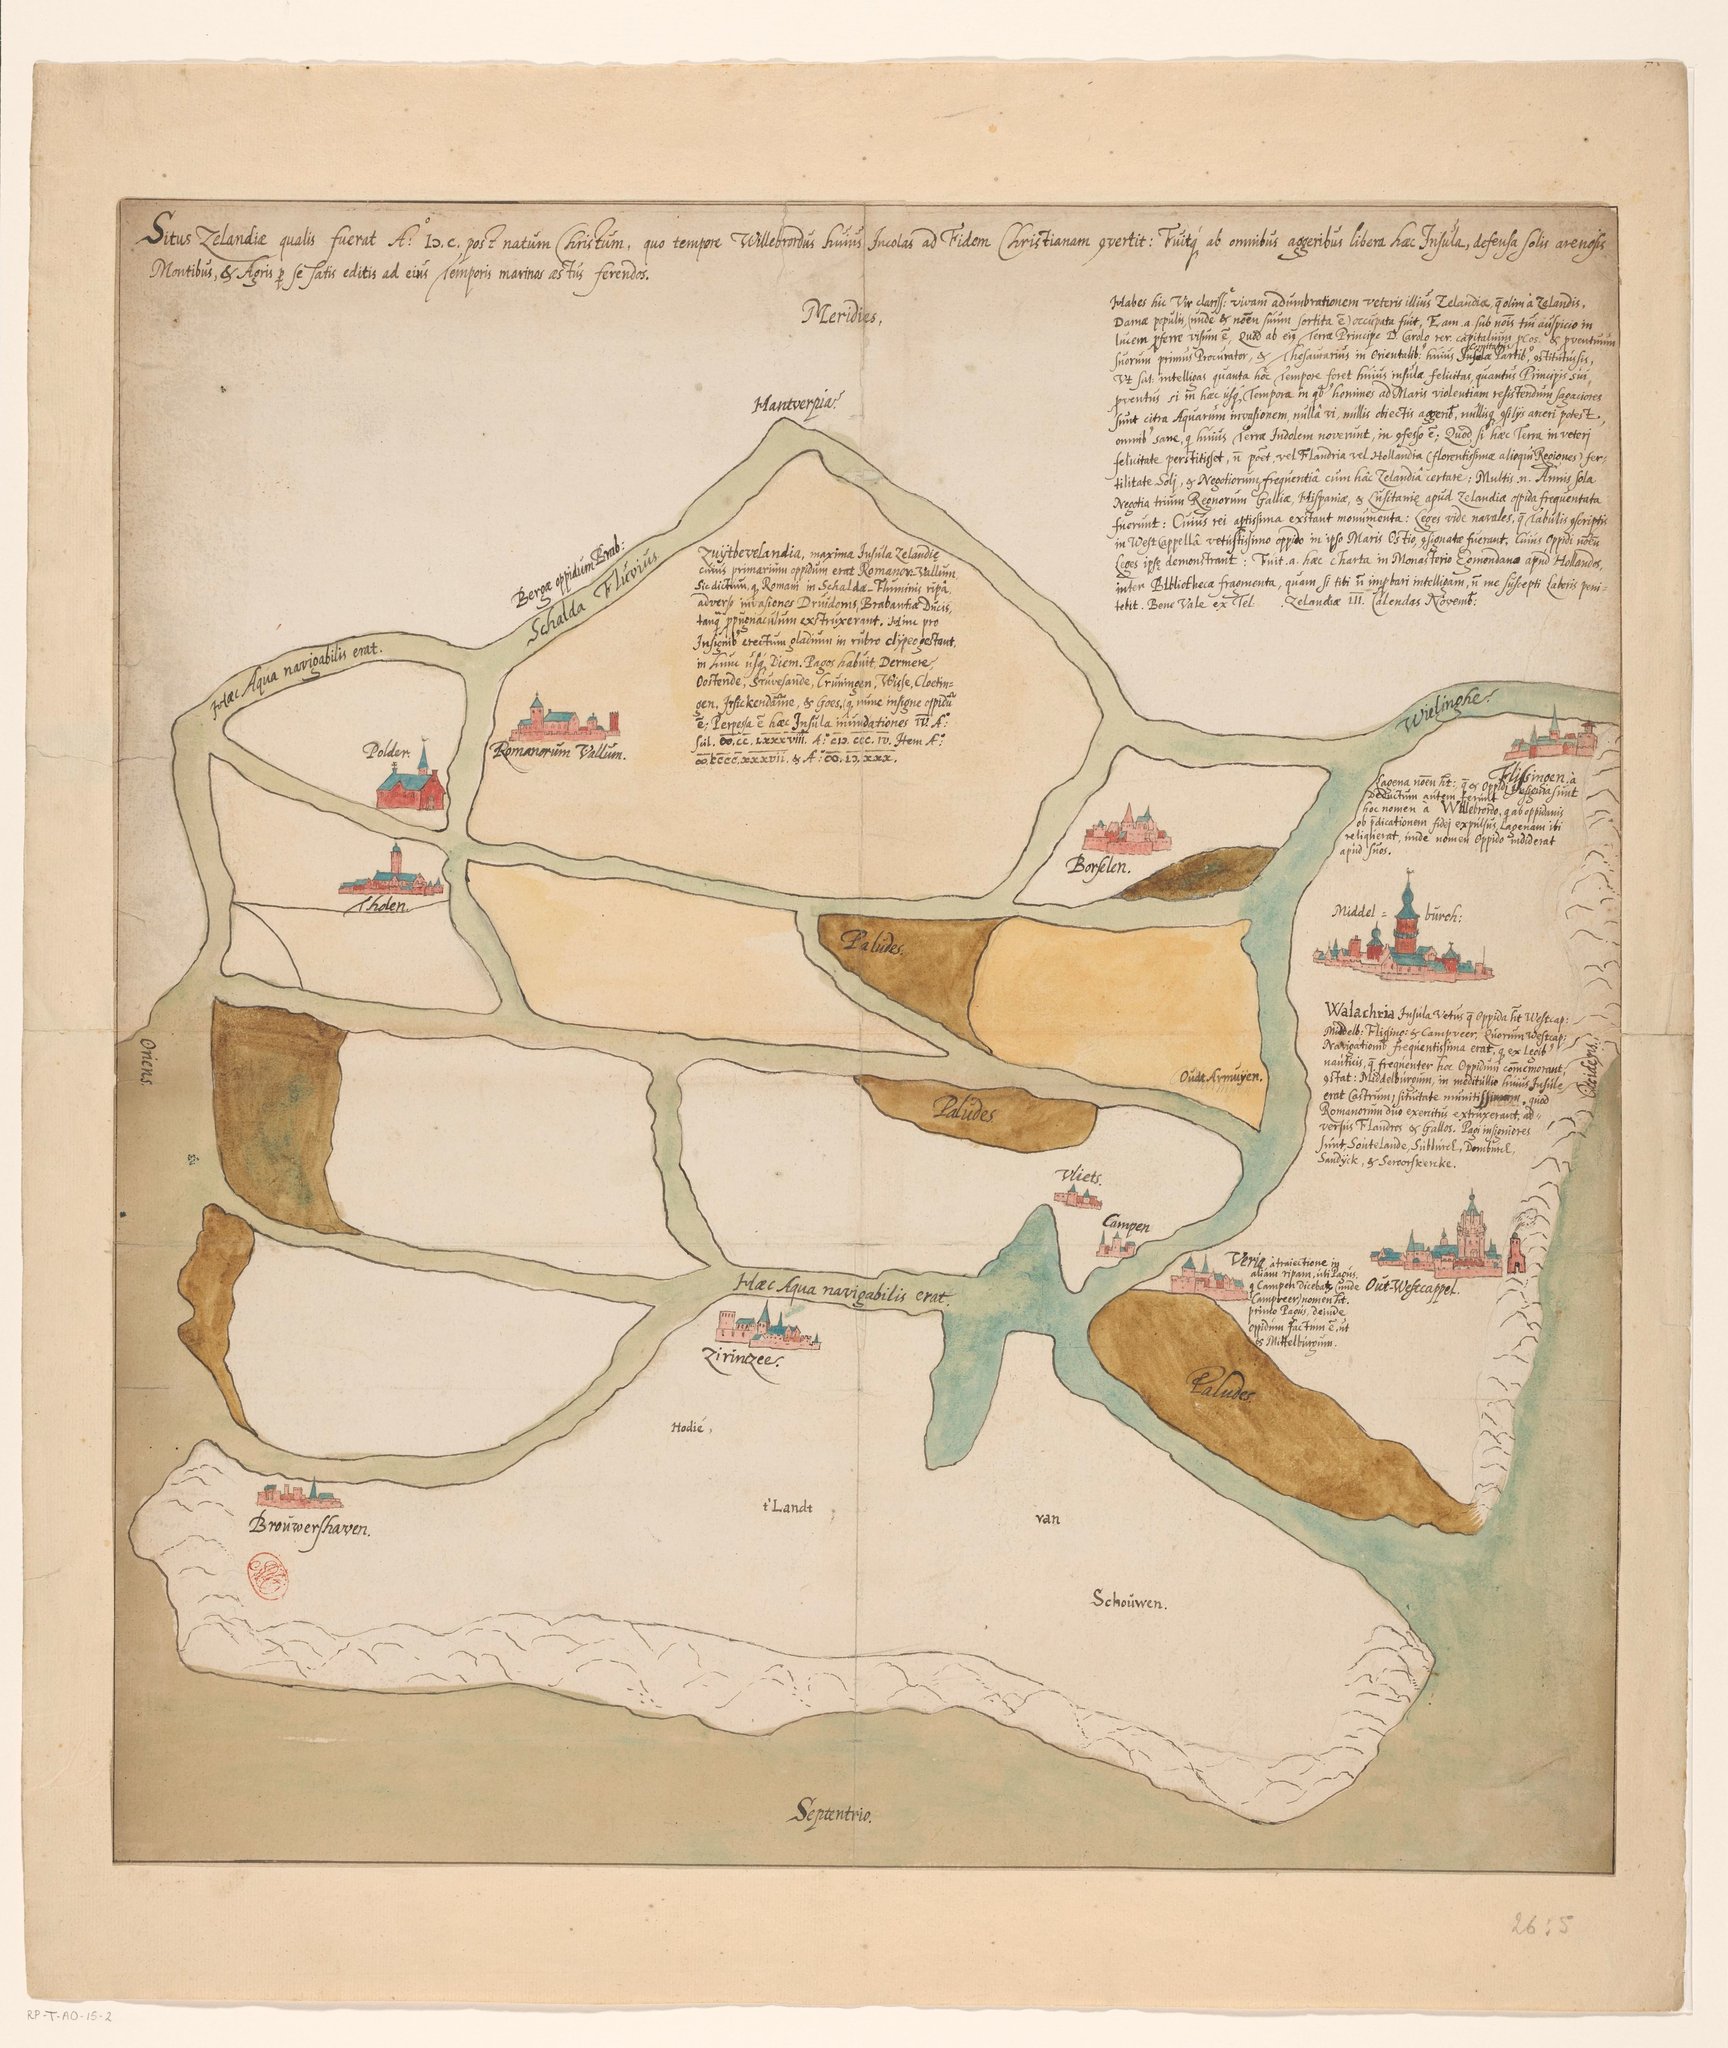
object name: map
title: Situs Zelandiae qualis fuerat a:o IƆC post natum Christum, quo tempore Willebrodus huius incolas ad fidem christianam covertit (…)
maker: Anonymous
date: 1650-1749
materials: ink, paper, pencil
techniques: brush, pen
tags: maps of separate countries or regions, zeeland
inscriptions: collector's mark: Lugt 195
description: Kaart van Zeeland zoals het gebied eruit zou hebben gezien rond 600 en toen Willibrord de bewoners tot het christendom bekeerde. Oriëntatie: noorden onder.